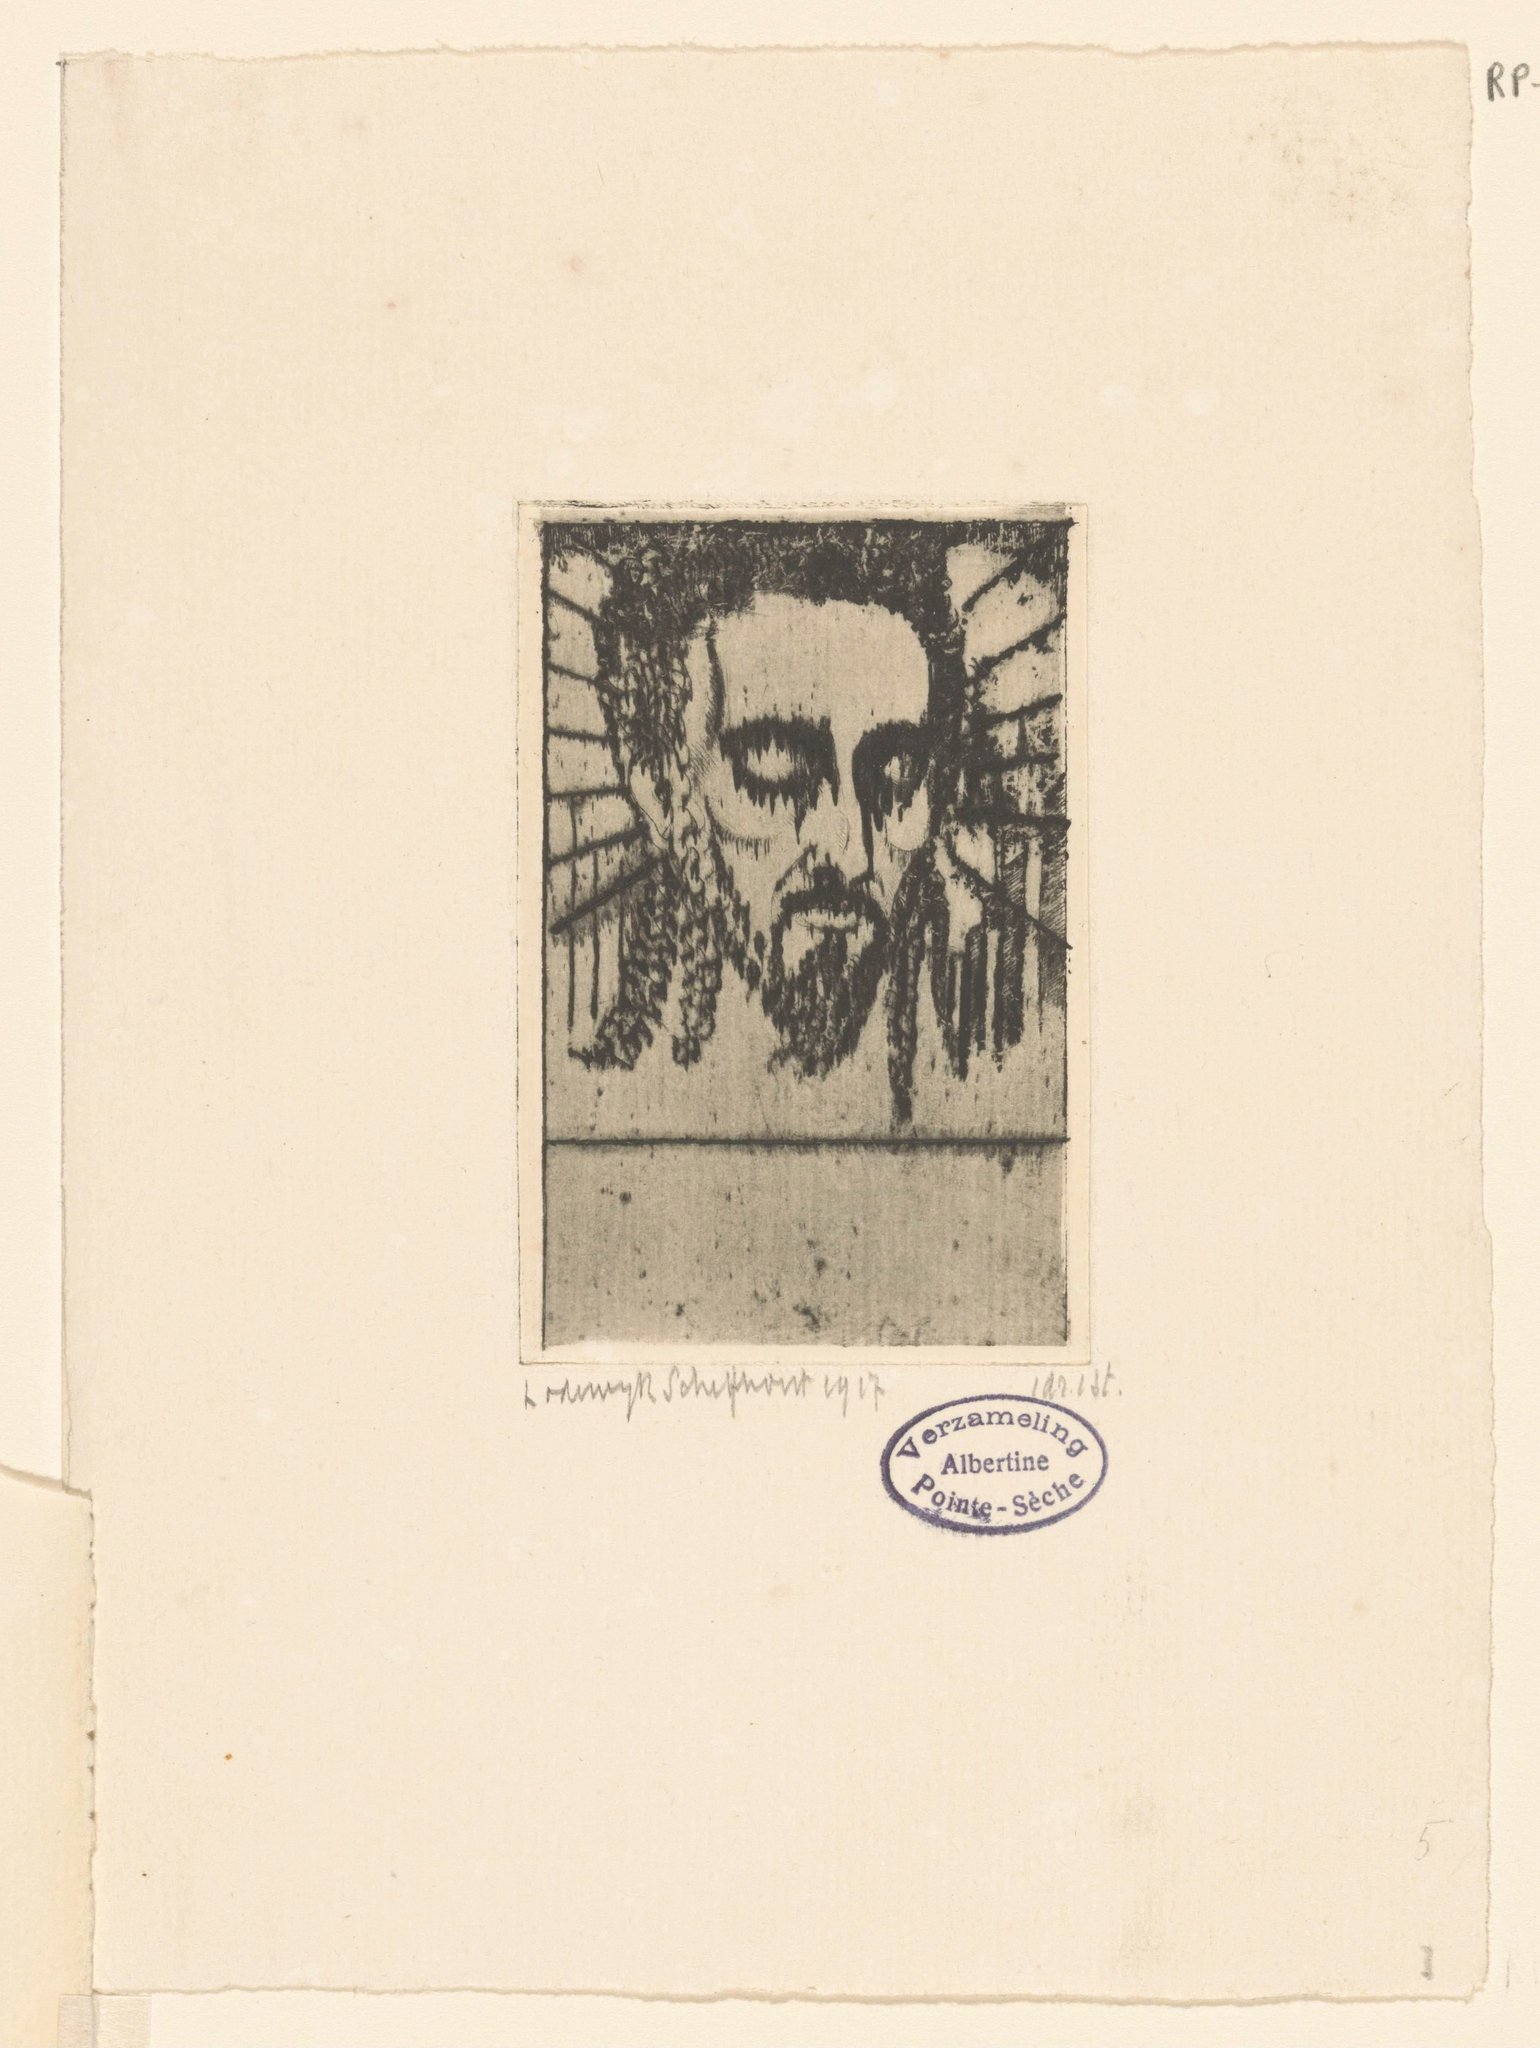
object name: print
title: Tête de Christ III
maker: lodewijk schelfhout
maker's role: draughtsman, print maker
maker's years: 1881-1943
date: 1917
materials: paper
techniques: drypoint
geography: netherlands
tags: rays as nimbus, christ as adult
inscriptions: collector's mark: Lugt 5i, collector's mark: Lugt 2228, collector's mark: Lugt 2760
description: Het hoofd van Christus, omgeven door lichtstralen.